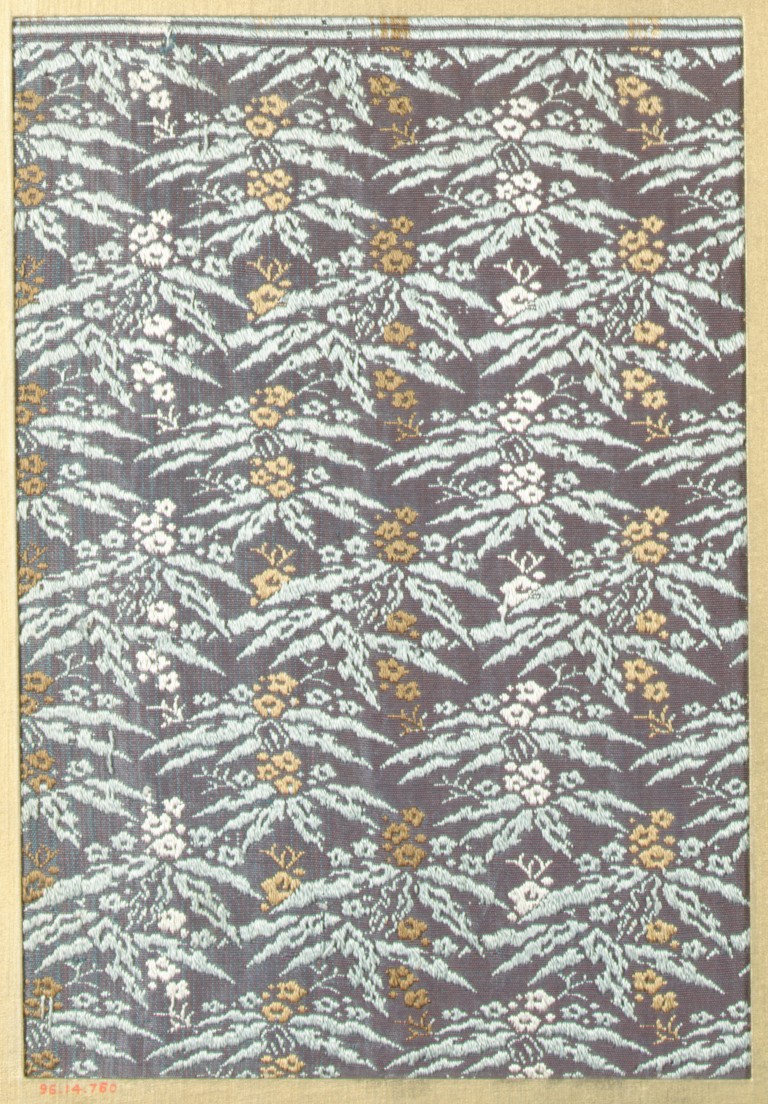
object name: piece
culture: japanese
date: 1701-1900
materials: silk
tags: flowers